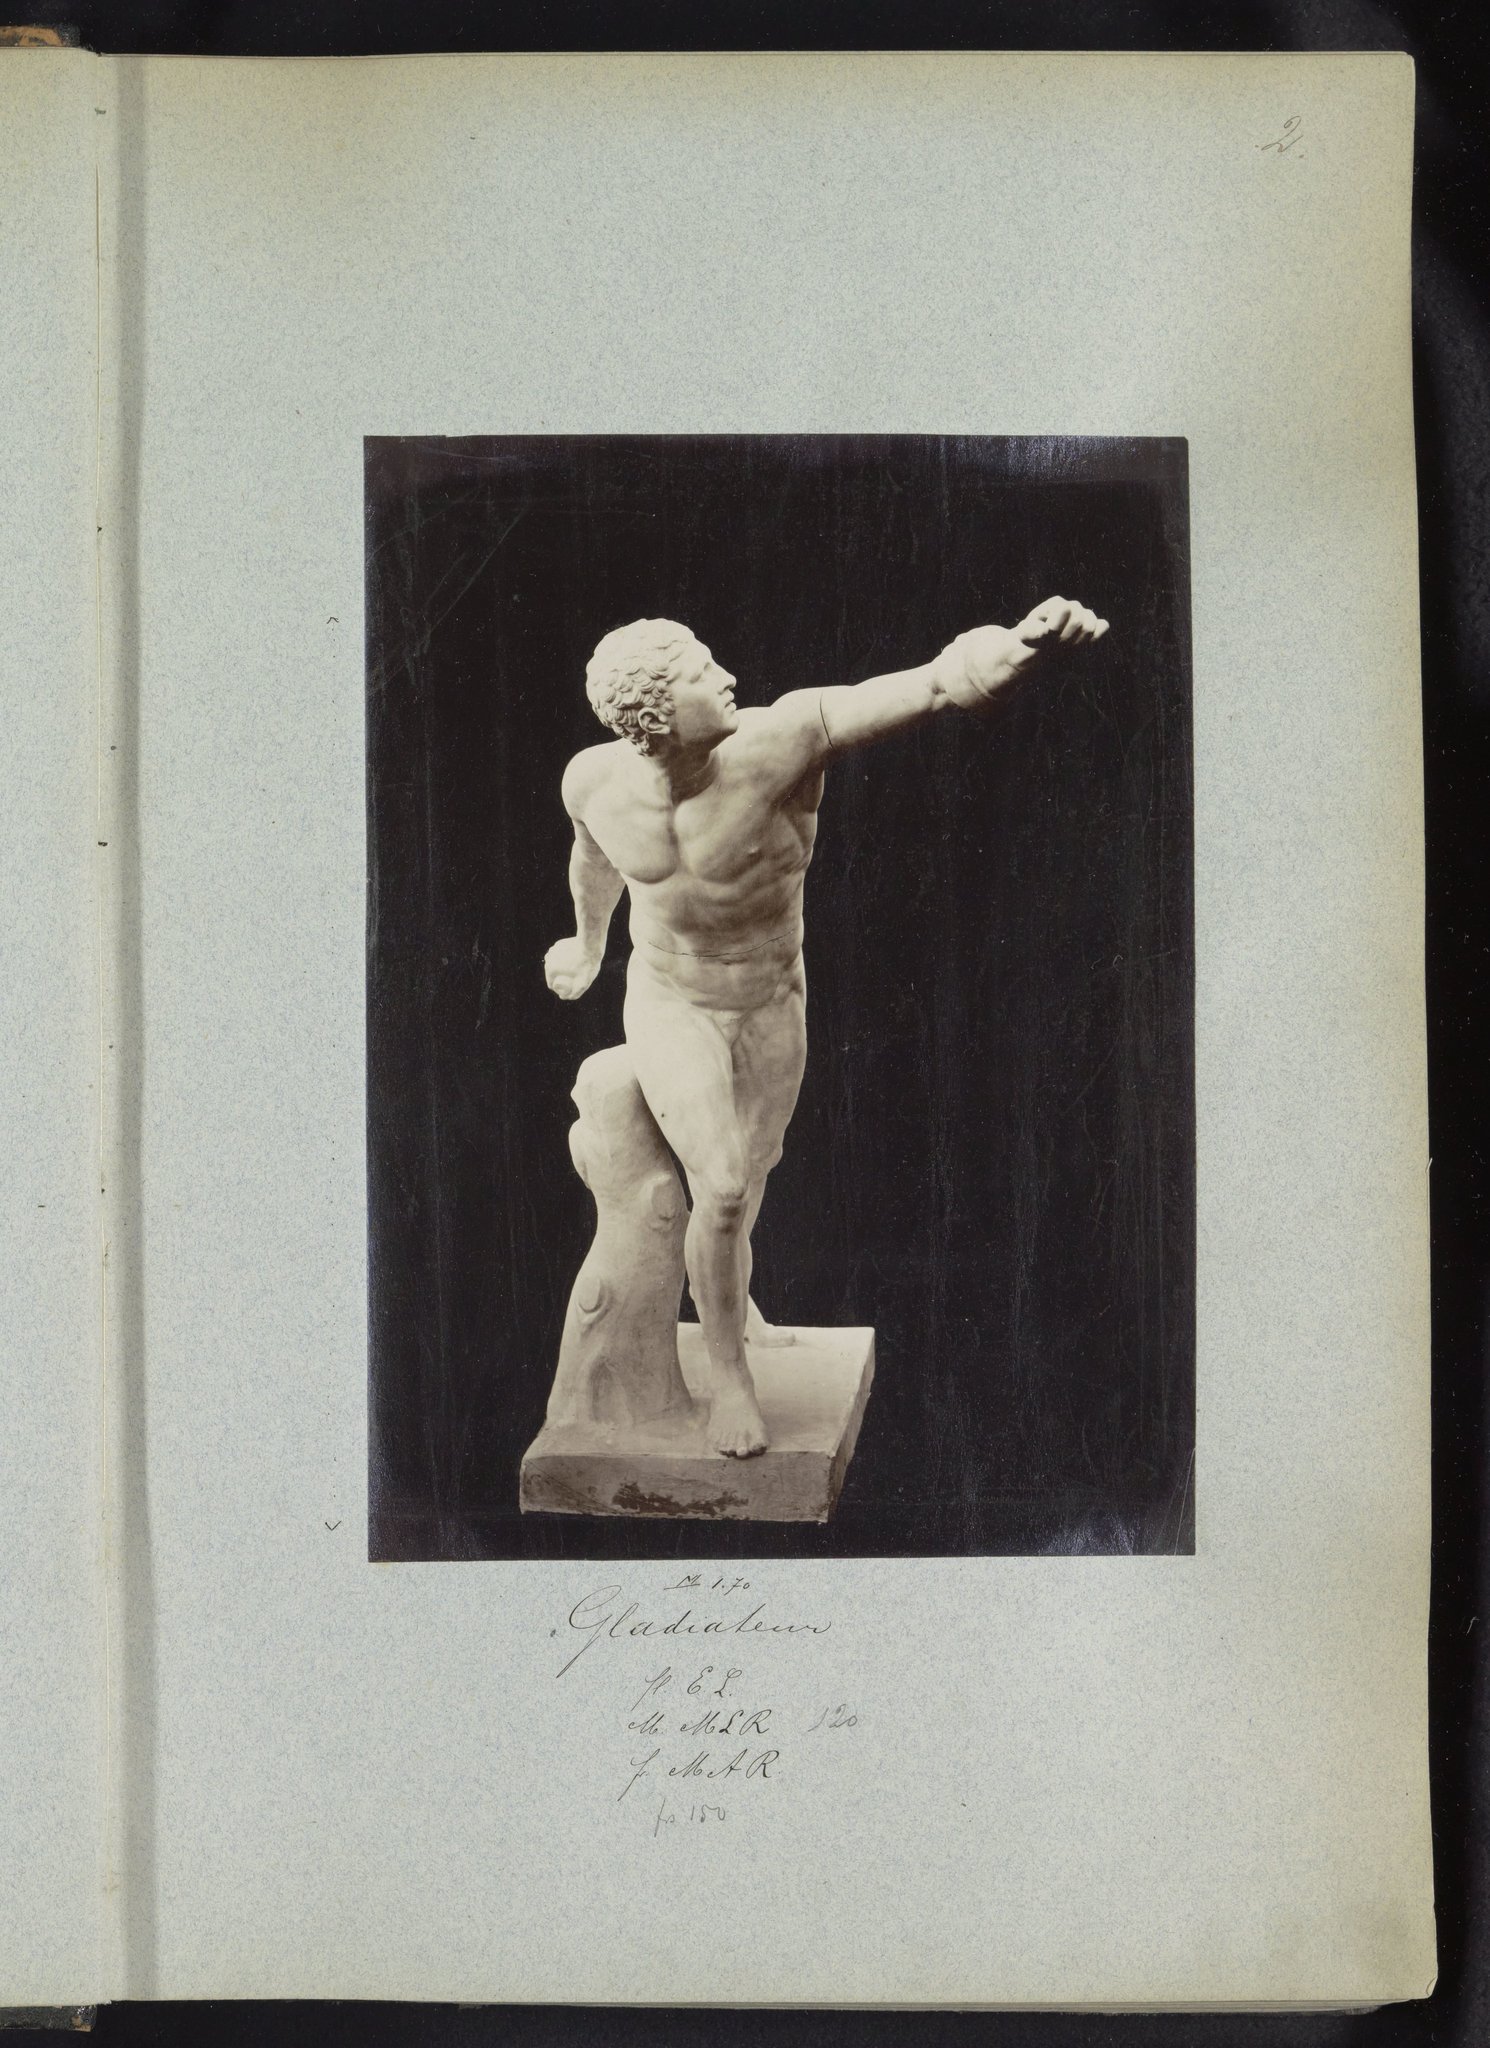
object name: album leaf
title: Gipsen afgietsel van een sculptuur van een gladiator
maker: Anonymous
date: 1875-1900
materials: paper, photographic support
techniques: albumen print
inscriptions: annotation: ‘Gladiateur’, annotation, annotation: ‘M 1.70’